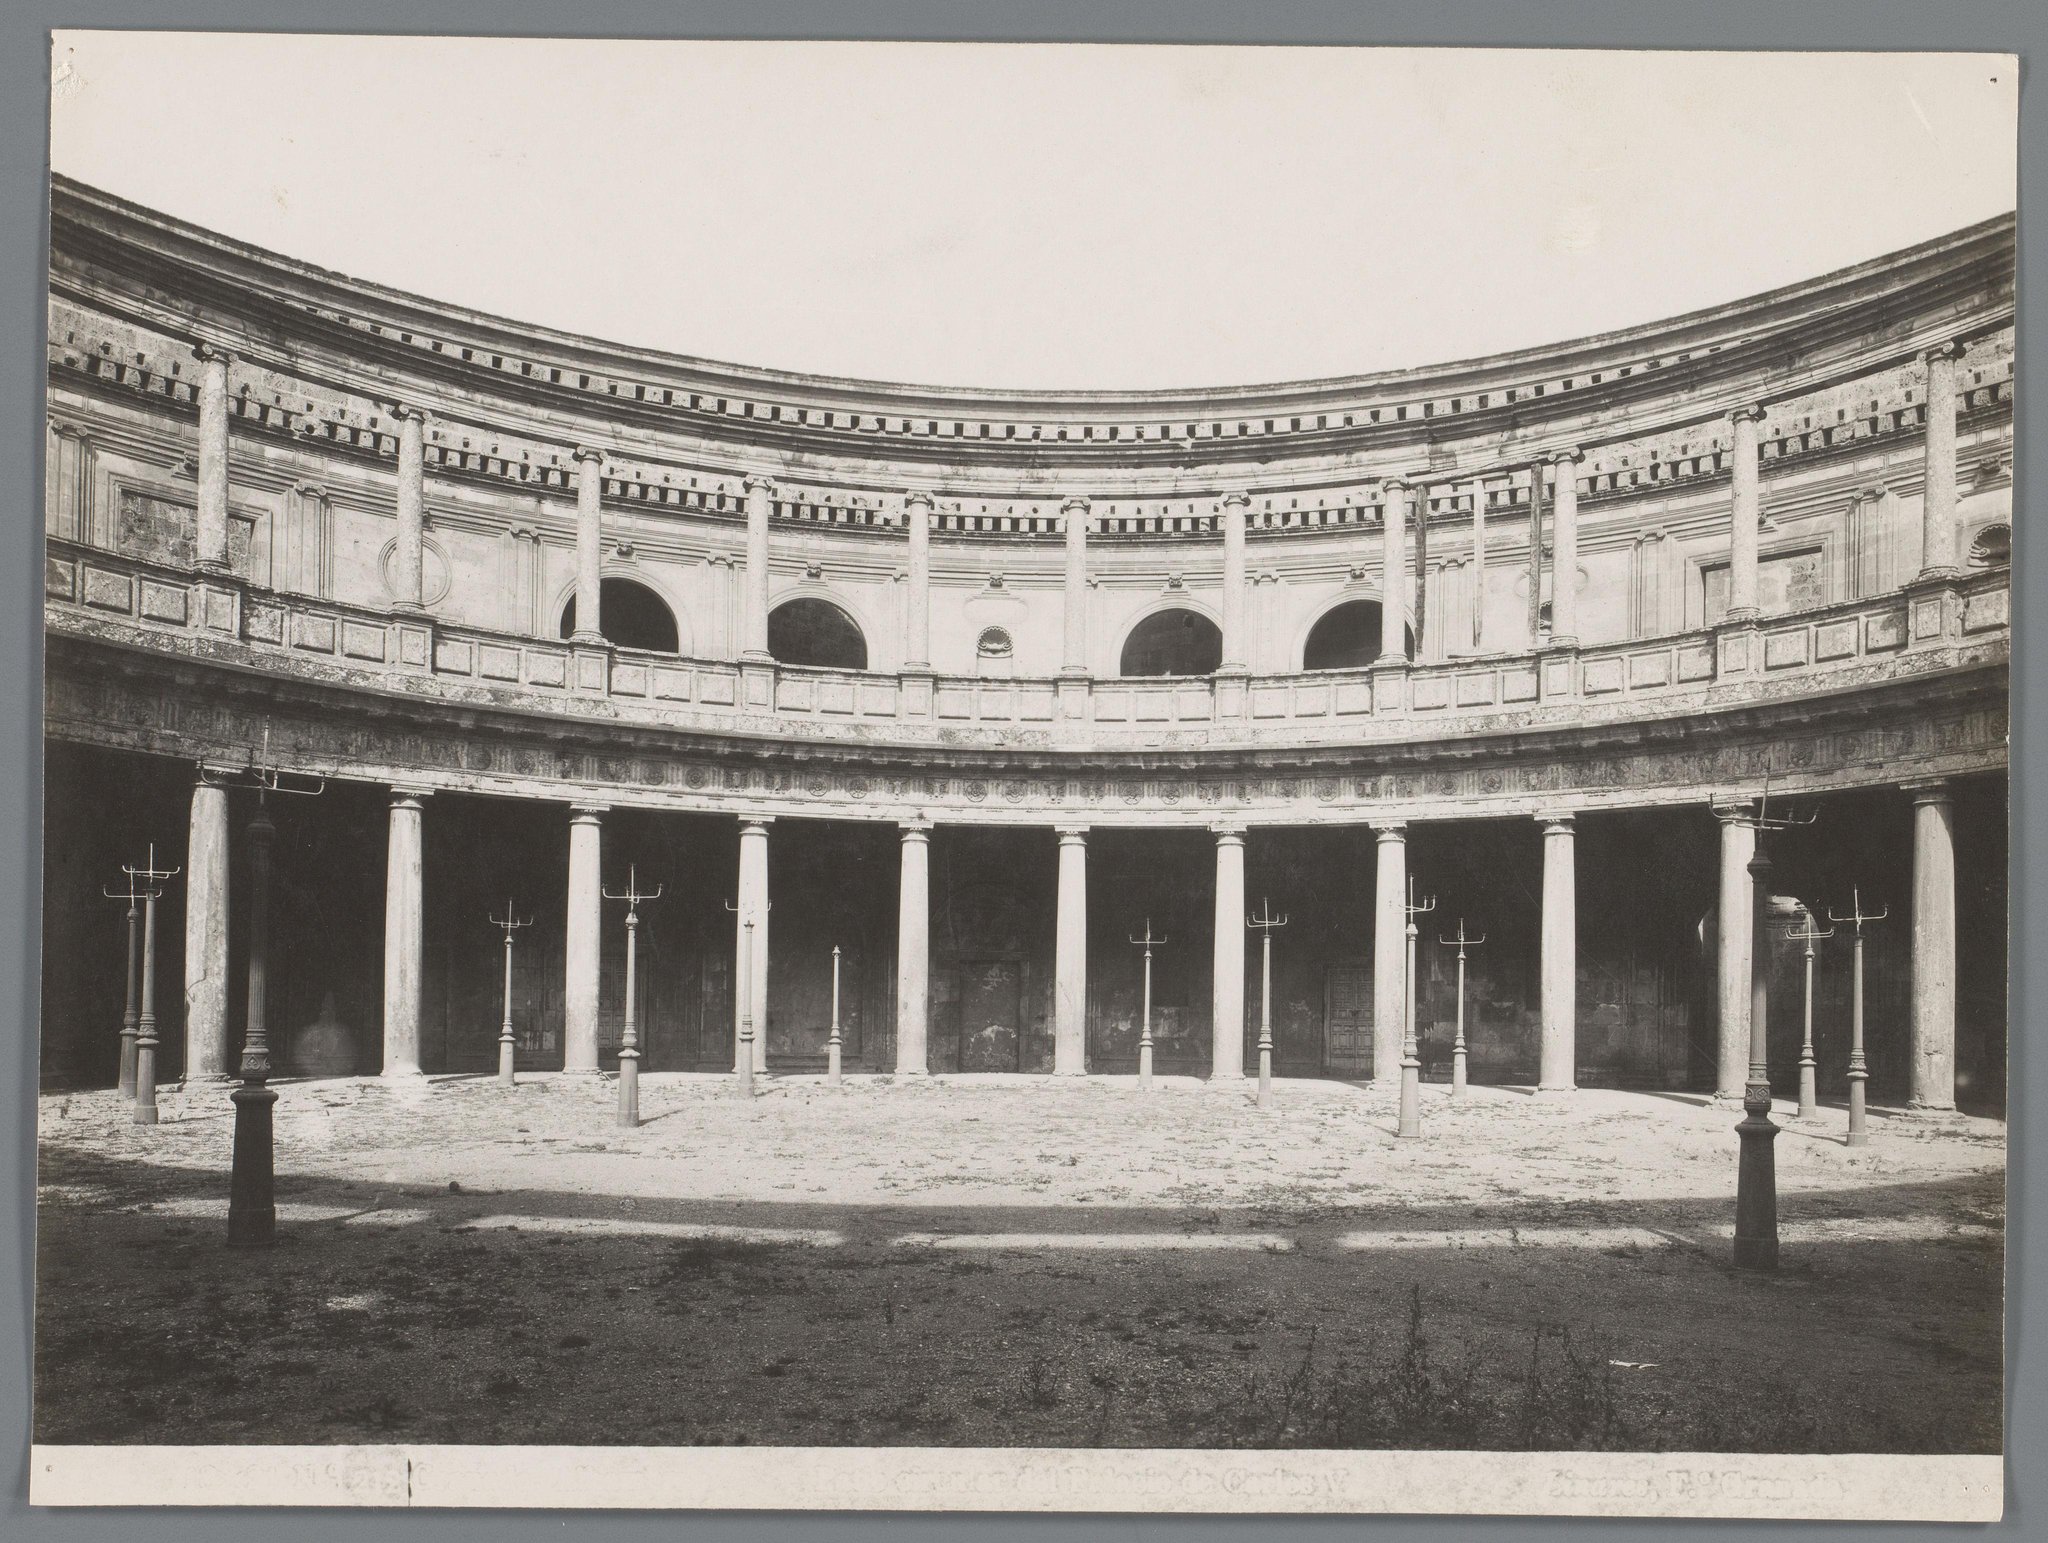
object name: photograph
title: Patio circular del Palacio de Charles V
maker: f. linares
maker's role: publisher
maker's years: 1870-1937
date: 1914-1937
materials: photographic support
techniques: gelatin silver print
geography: alhambra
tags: palace, inner court of palace or 'hôtel'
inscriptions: inscription: ‘18 x 24’, number: ‘212’